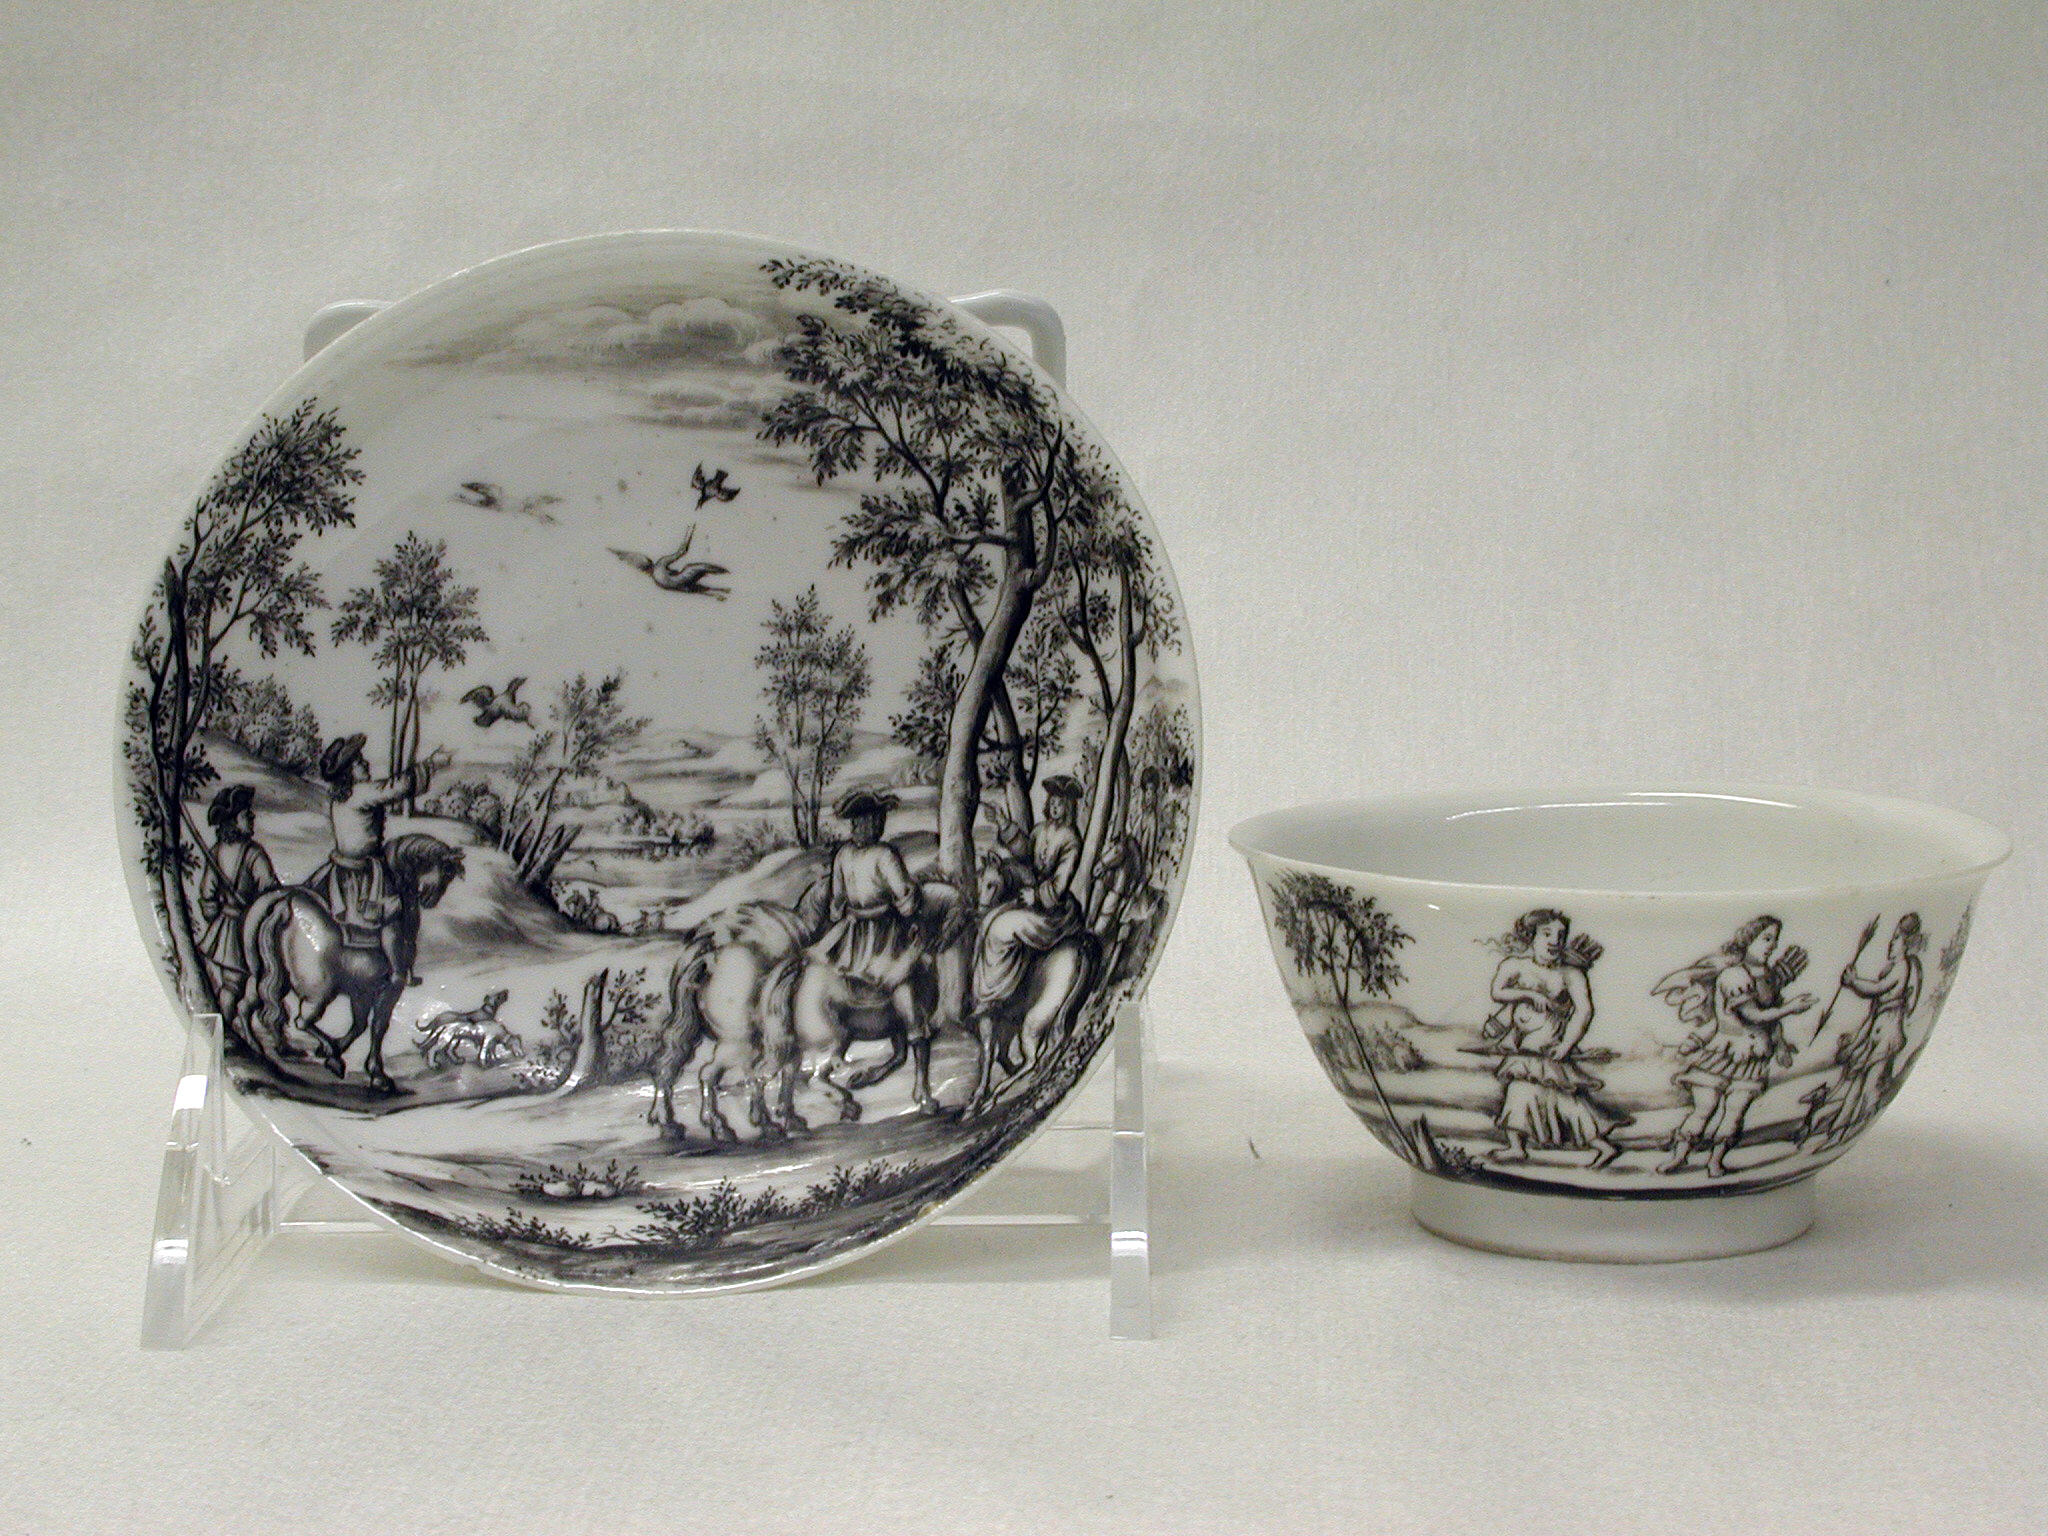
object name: teabowl and saucer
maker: meissen manufactory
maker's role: manufactory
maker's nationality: german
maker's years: 1710-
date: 1715-1720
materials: hard paste porcelain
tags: men,horses,trees